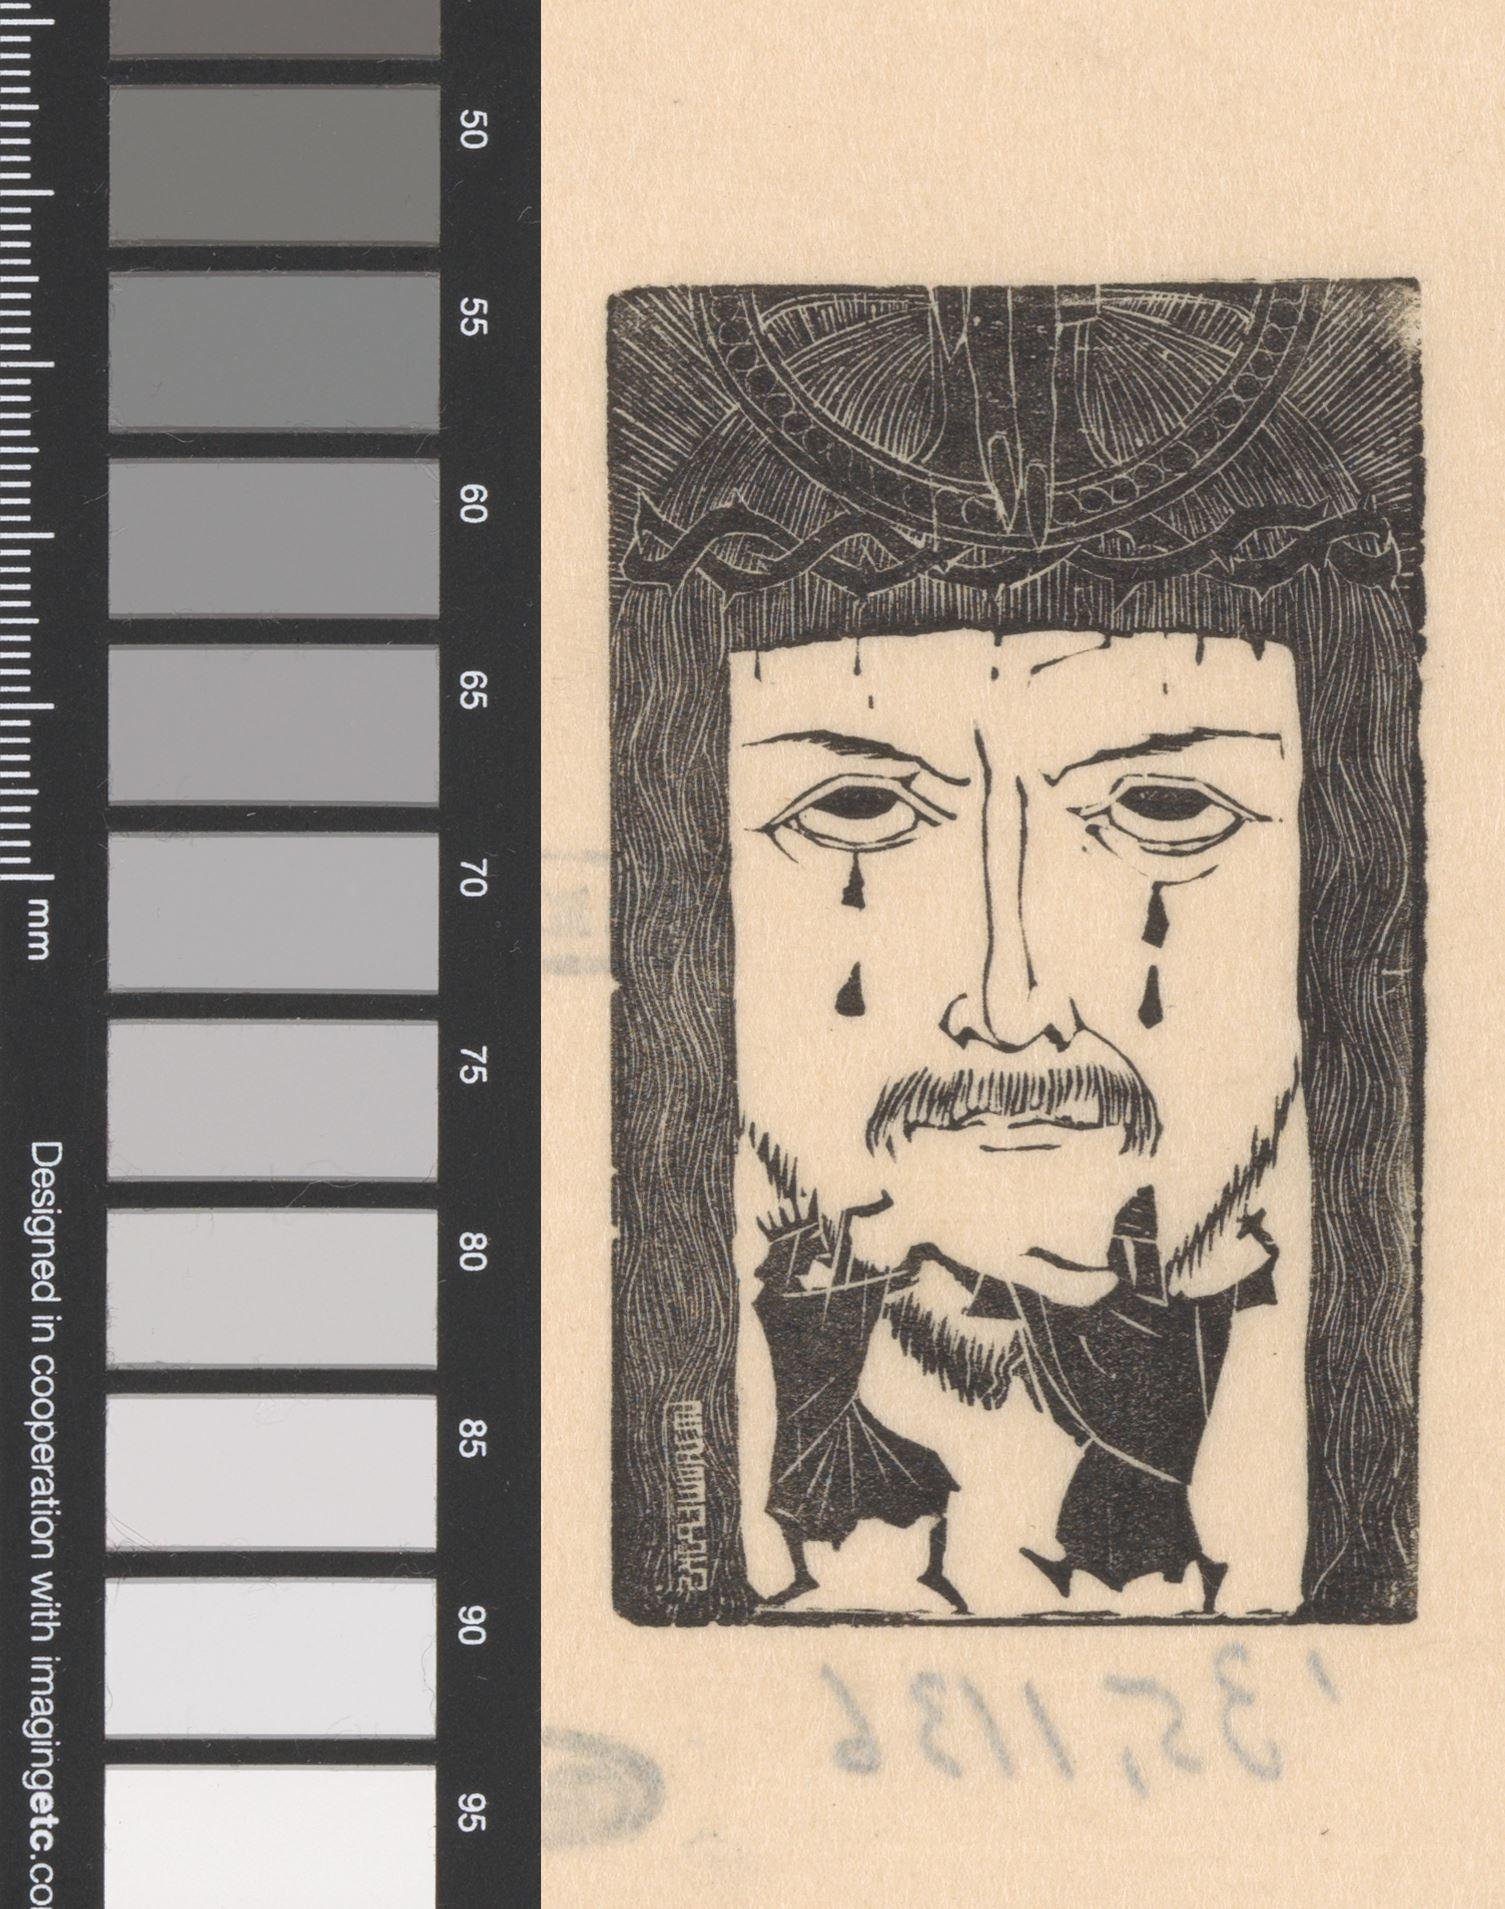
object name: illustration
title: Bespotting van Christus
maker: mathieu lauweriks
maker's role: designer, draughtsman, print maker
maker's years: 1864-1932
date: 1895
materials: paper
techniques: woodcut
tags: personifications of countries, nations, states, districts, etc., the church personified, 'ecclesia', usually with chalice and banner, mockings of christ, who may be blindfolded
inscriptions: collector's mark: Lugt 2228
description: Prent mogelijk gebruikt als illustratie van het gedicht 'Aan haar' in: Licht en waarheid. Orgaan van de vereeniging 'Wie Denkt Overwint'. Amsterdam: Wie Denkt Overwint, 5 januari 1895. Prent mogelijk ook gebruikt voor: Wendingen. Maandblad voor bouwen en sieren van "Architectura et Amicitia". Amsterdam: De Hooge Brug 1919. 7/8, p. 9. Het betreft een postume afdruk.